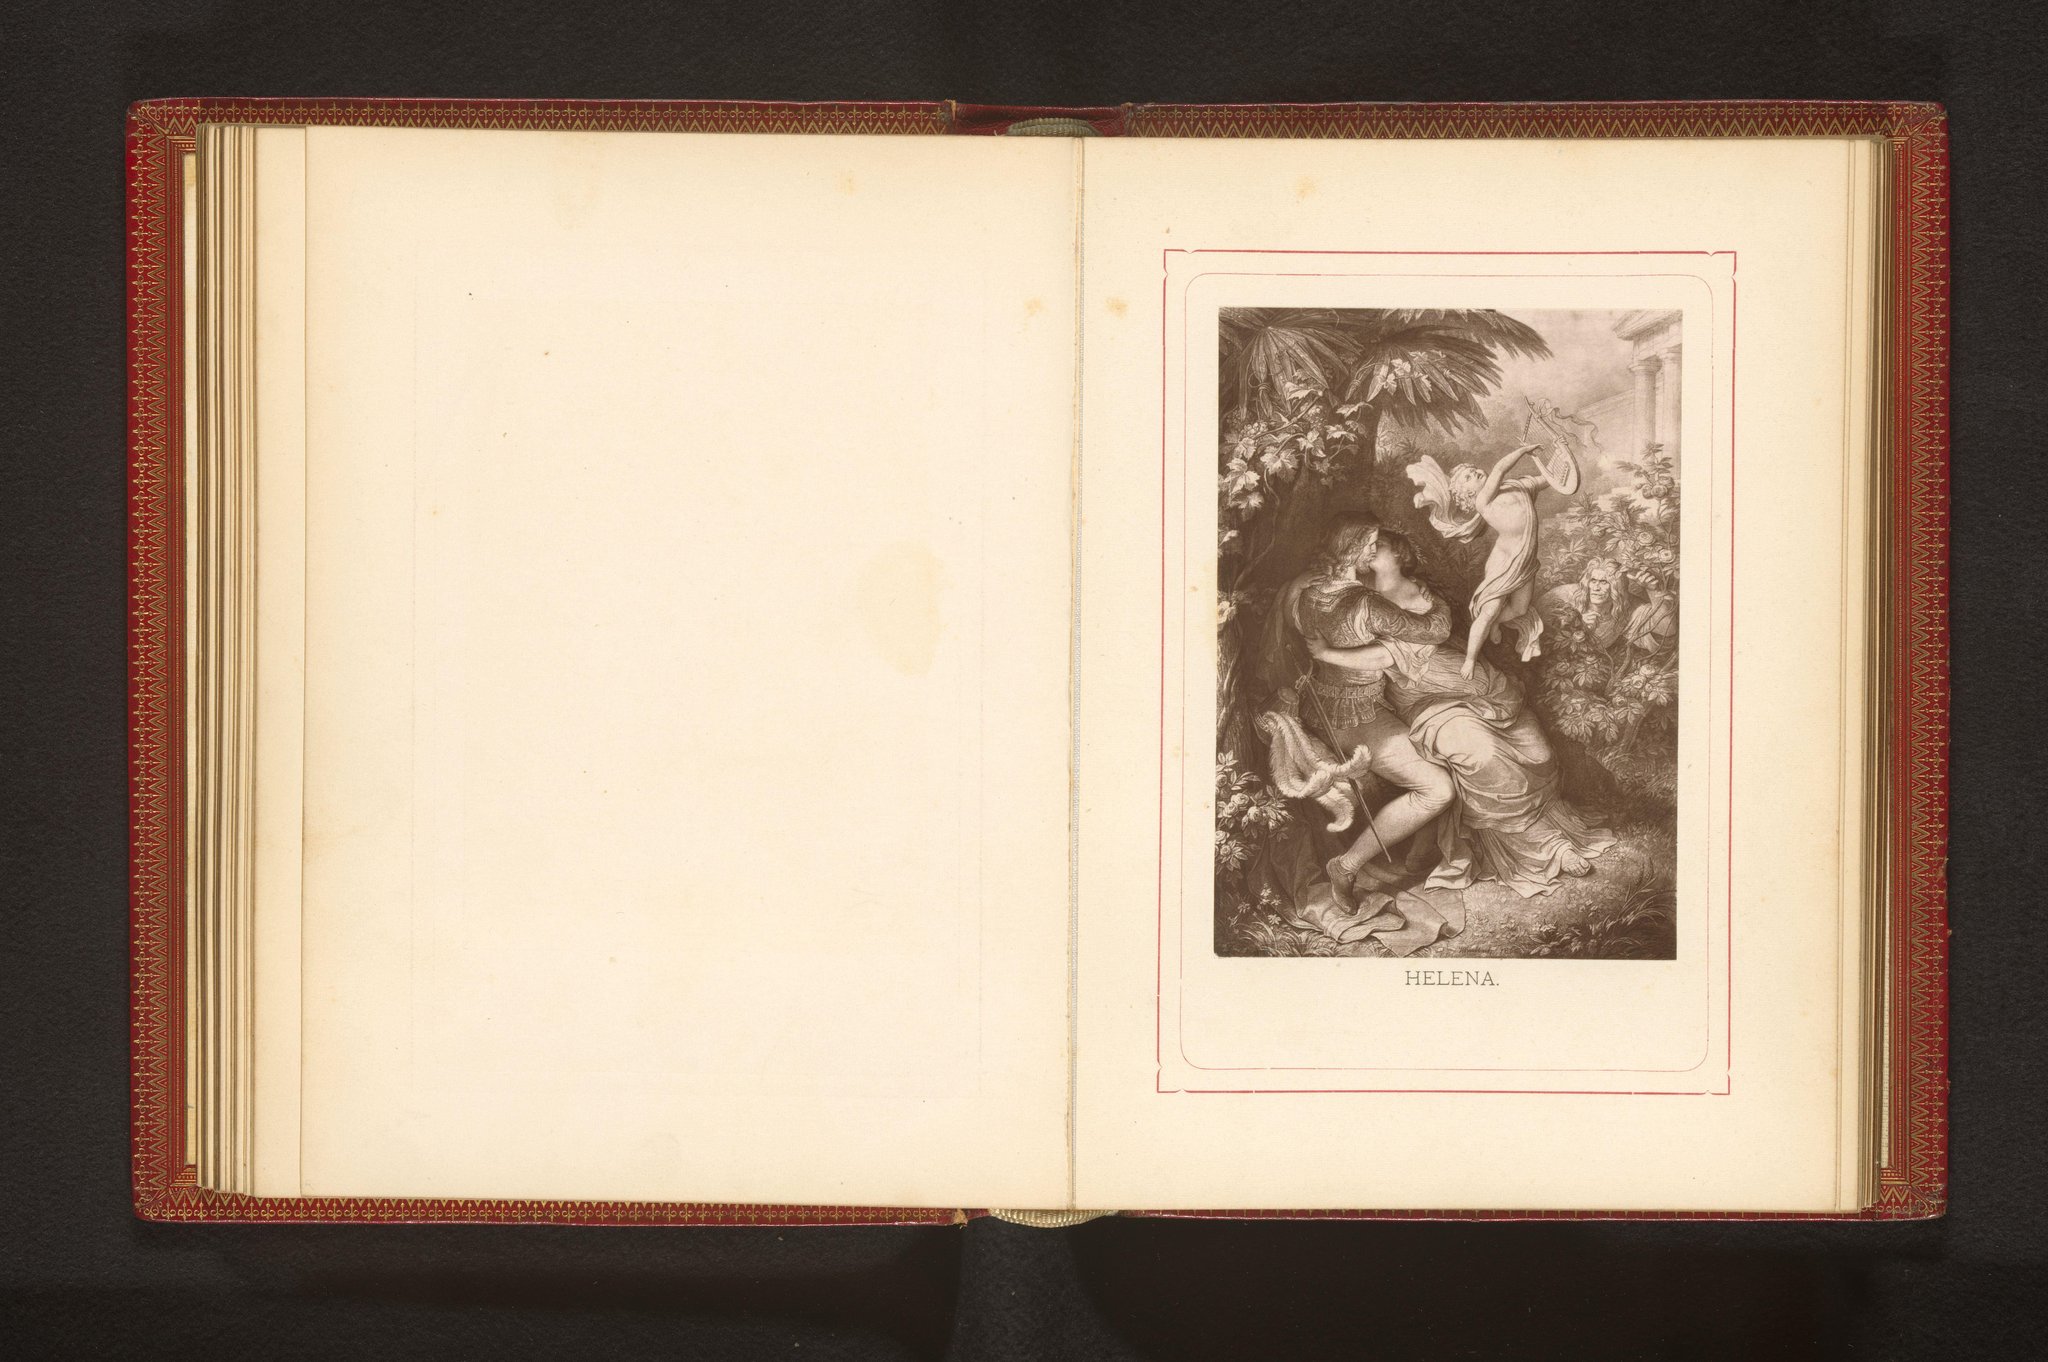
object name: photomechanical print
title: Helena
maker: Anonymous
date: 1875-1885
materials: paper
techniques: photograph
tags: (lovers) kissing each other, (scenes from) specific works of literature: goethe, faust